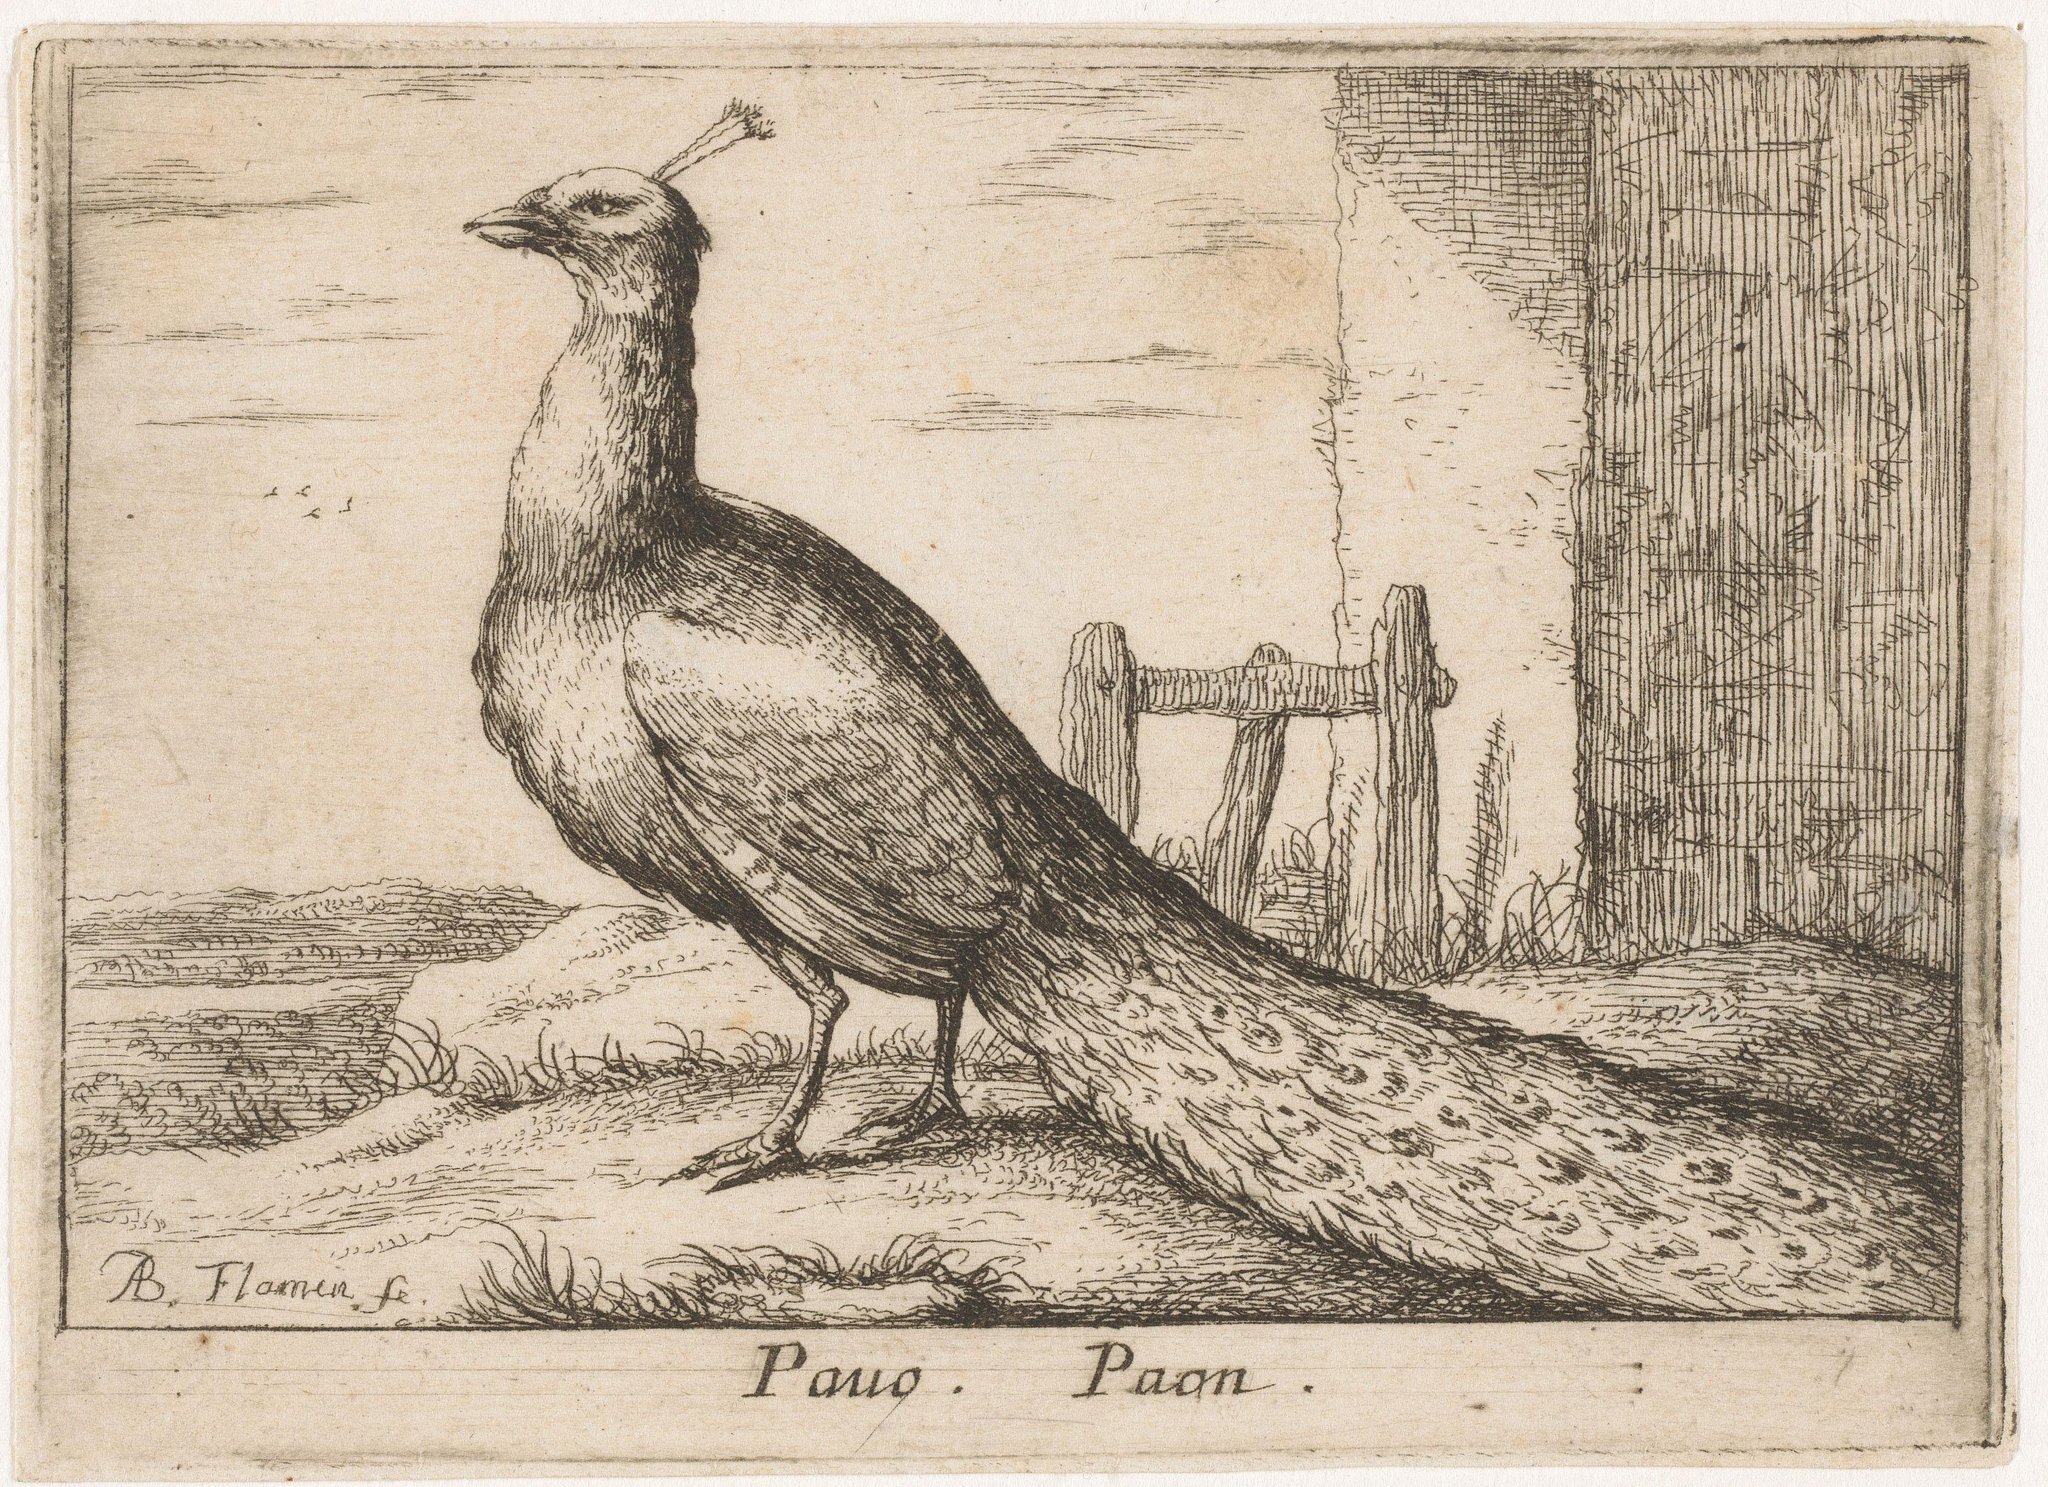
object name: print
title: Pauo. Paon.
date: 1659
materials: paper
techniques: etching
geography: france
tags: ornamental birds: peacock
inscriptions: collector's mark: Lugt 2228